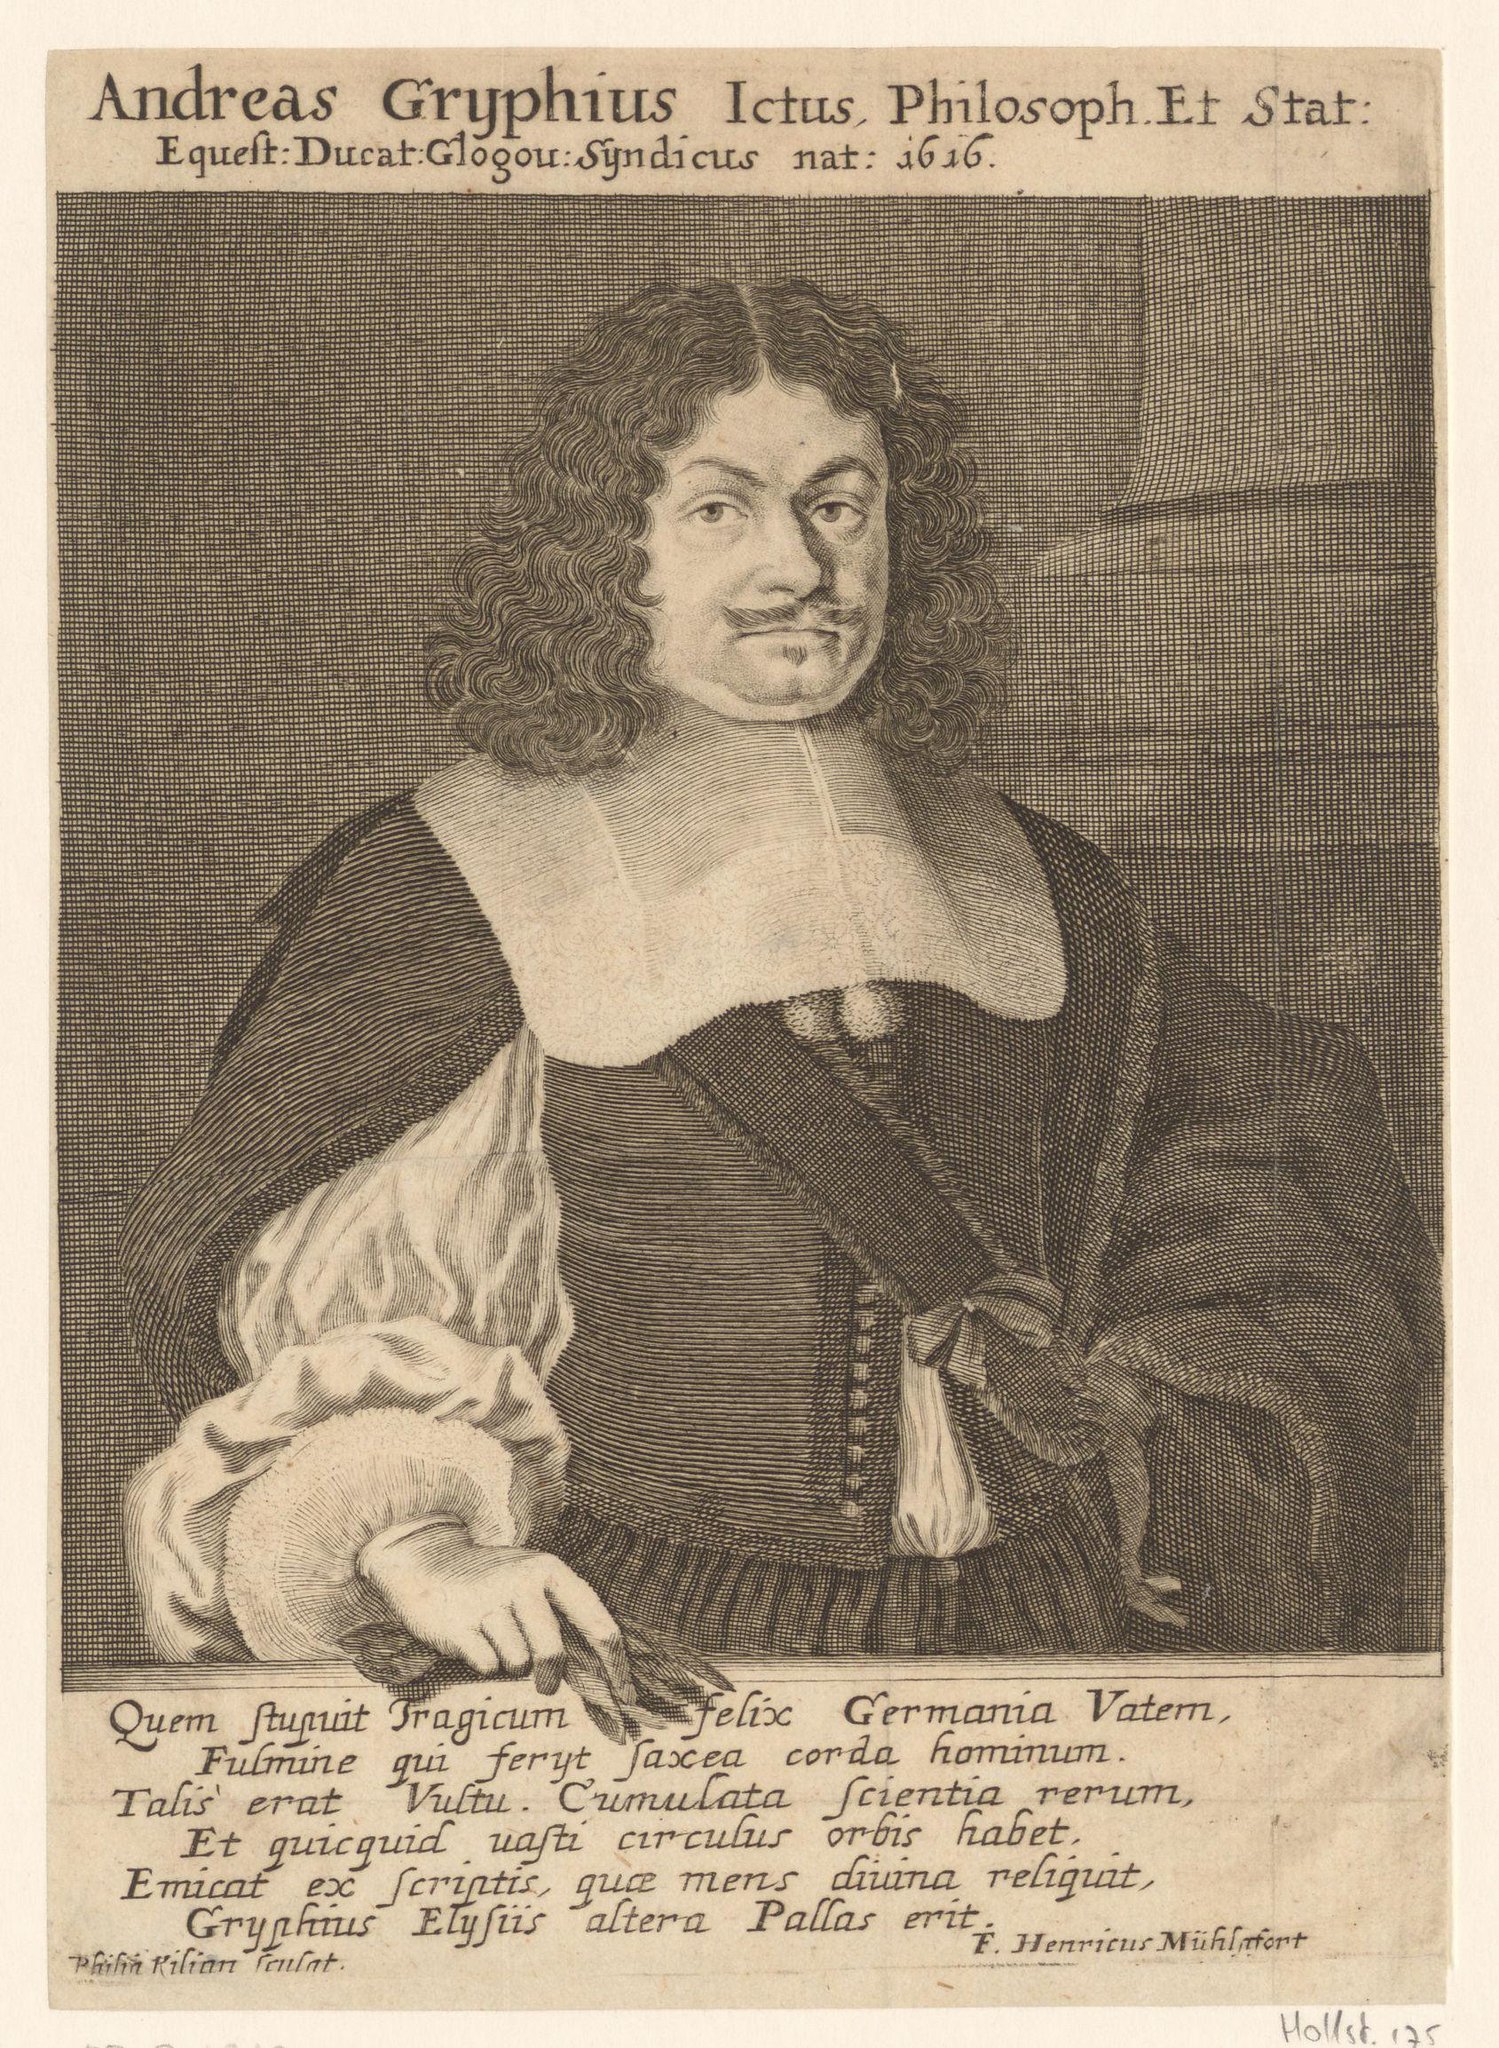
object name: print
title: Portret van Andreas Gryphius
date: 1638-1664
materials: paper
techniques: engraving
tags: historical persons, writer, poet, author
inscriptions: collector's mark: Lugt 2228